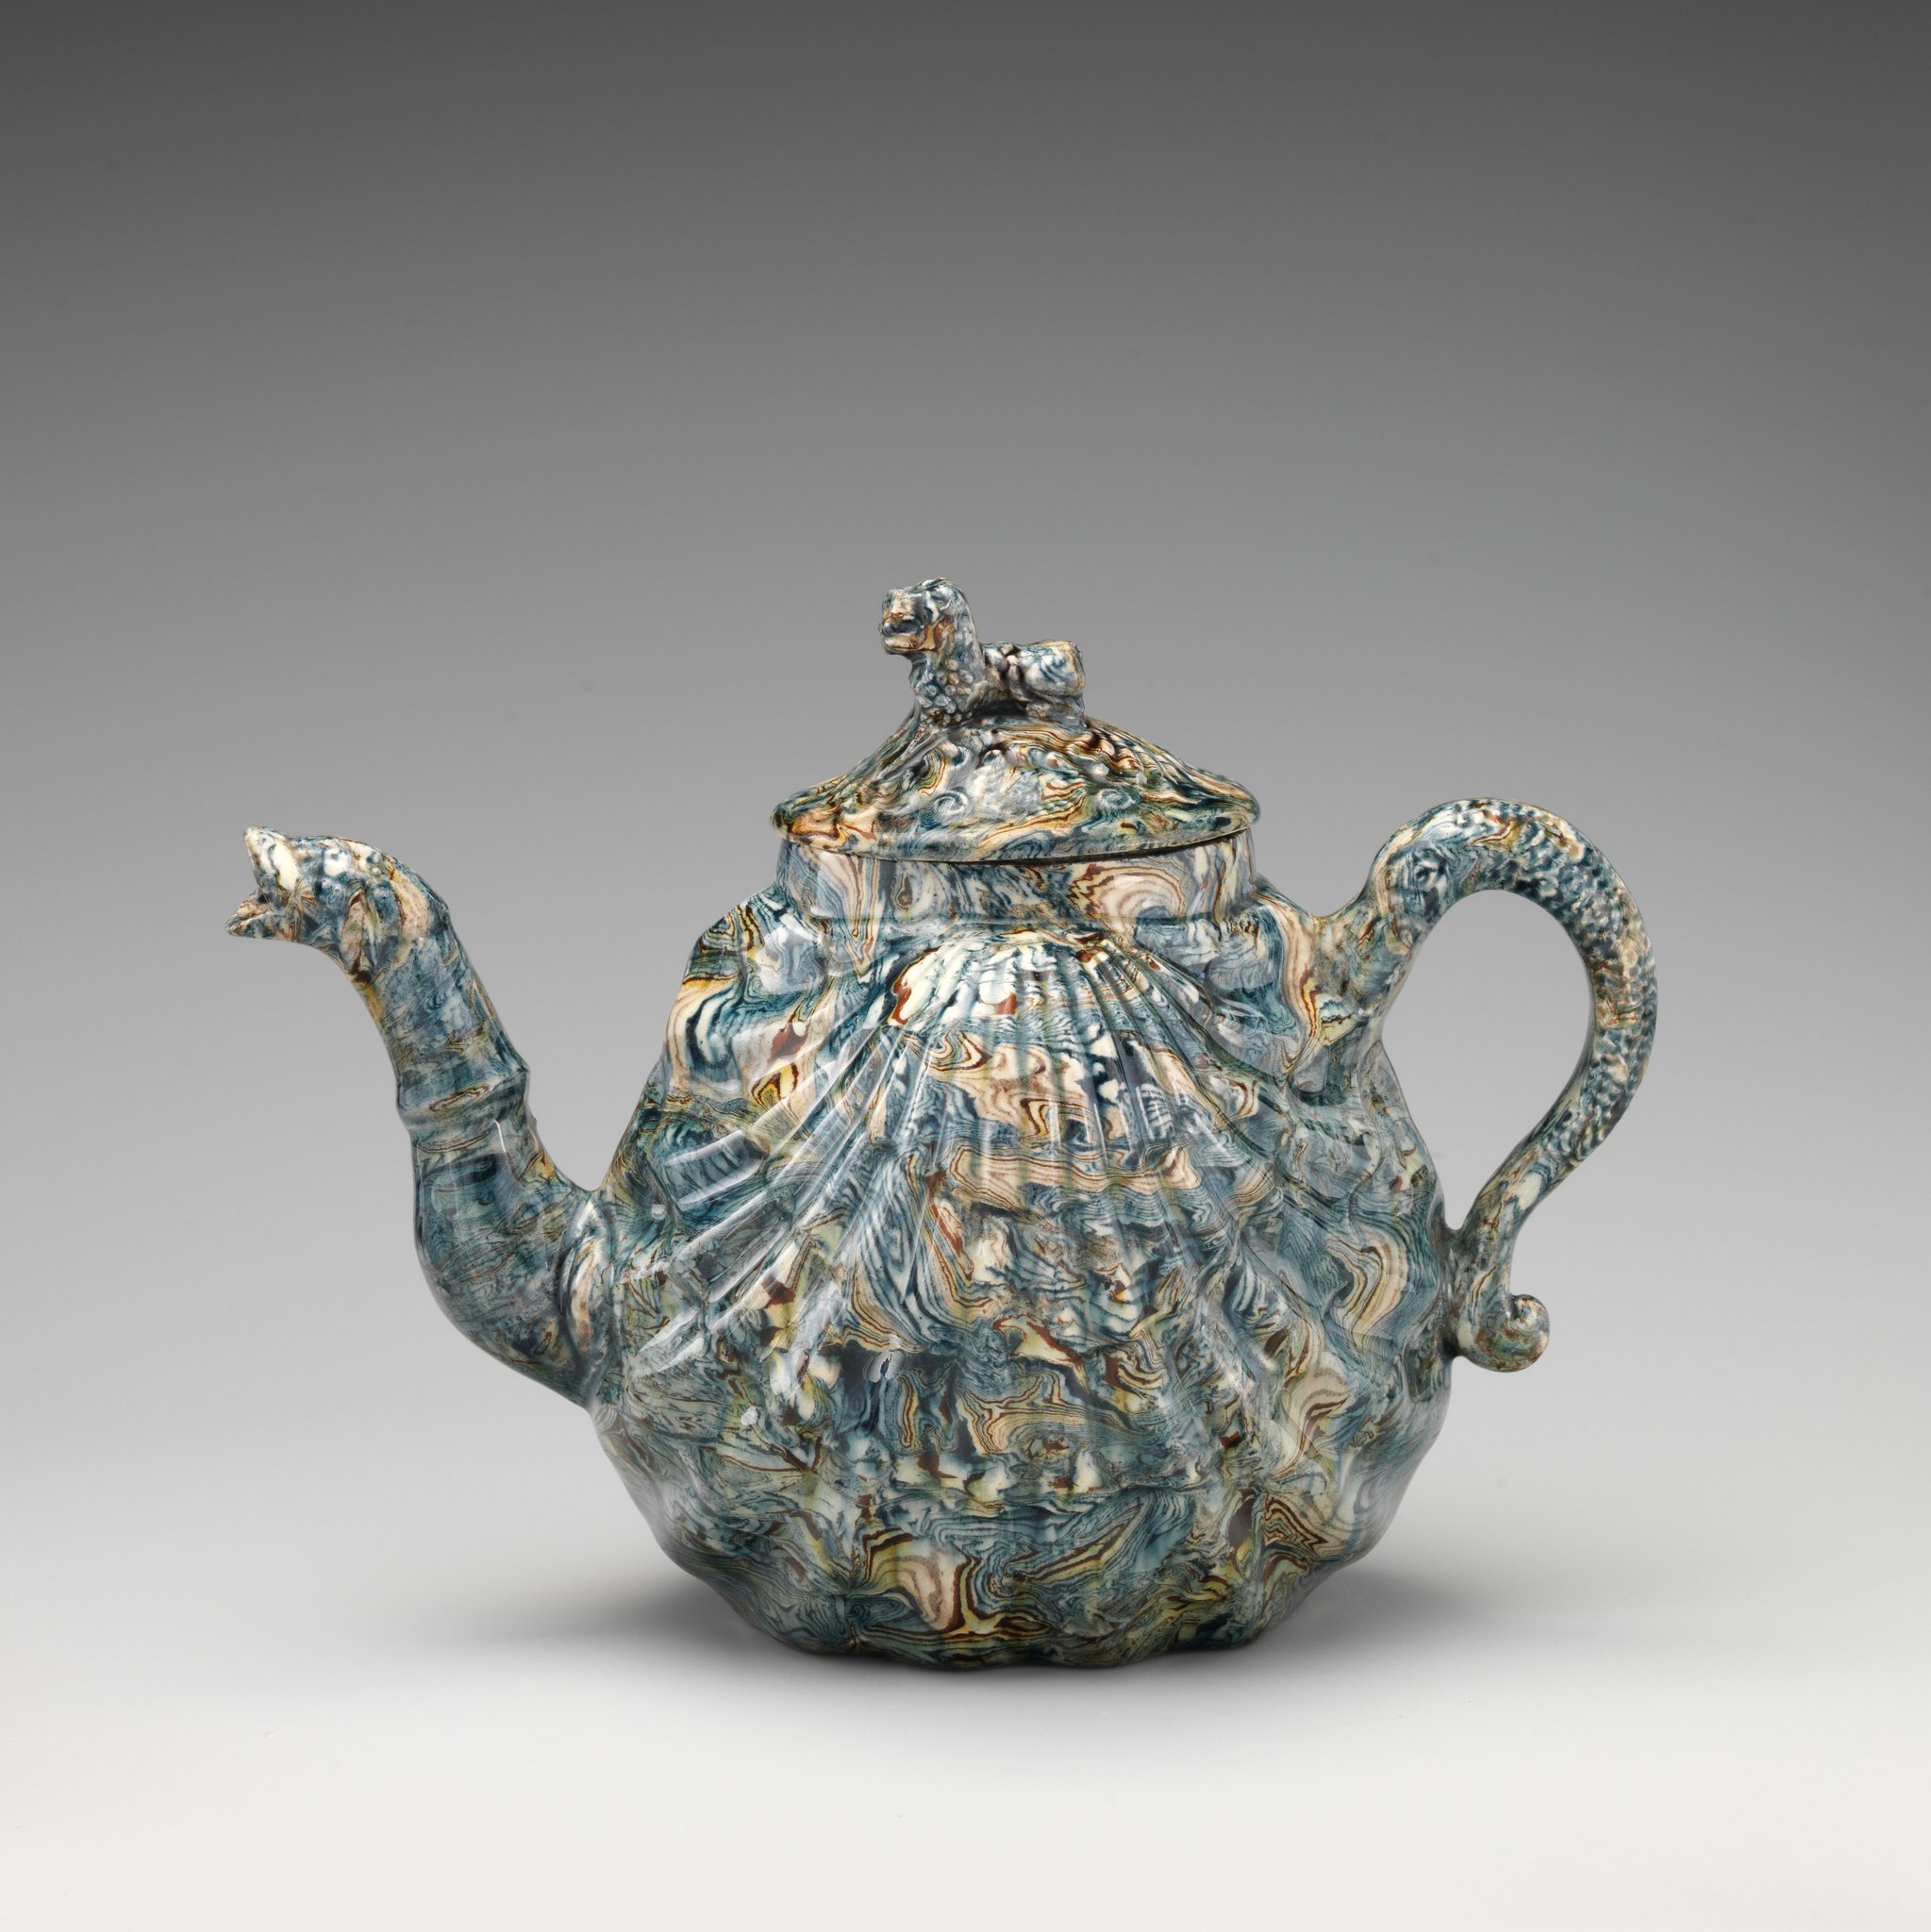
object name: teapot with cover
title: Teapot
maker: whieldon type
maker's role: maker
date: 1750-1765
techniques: glazing